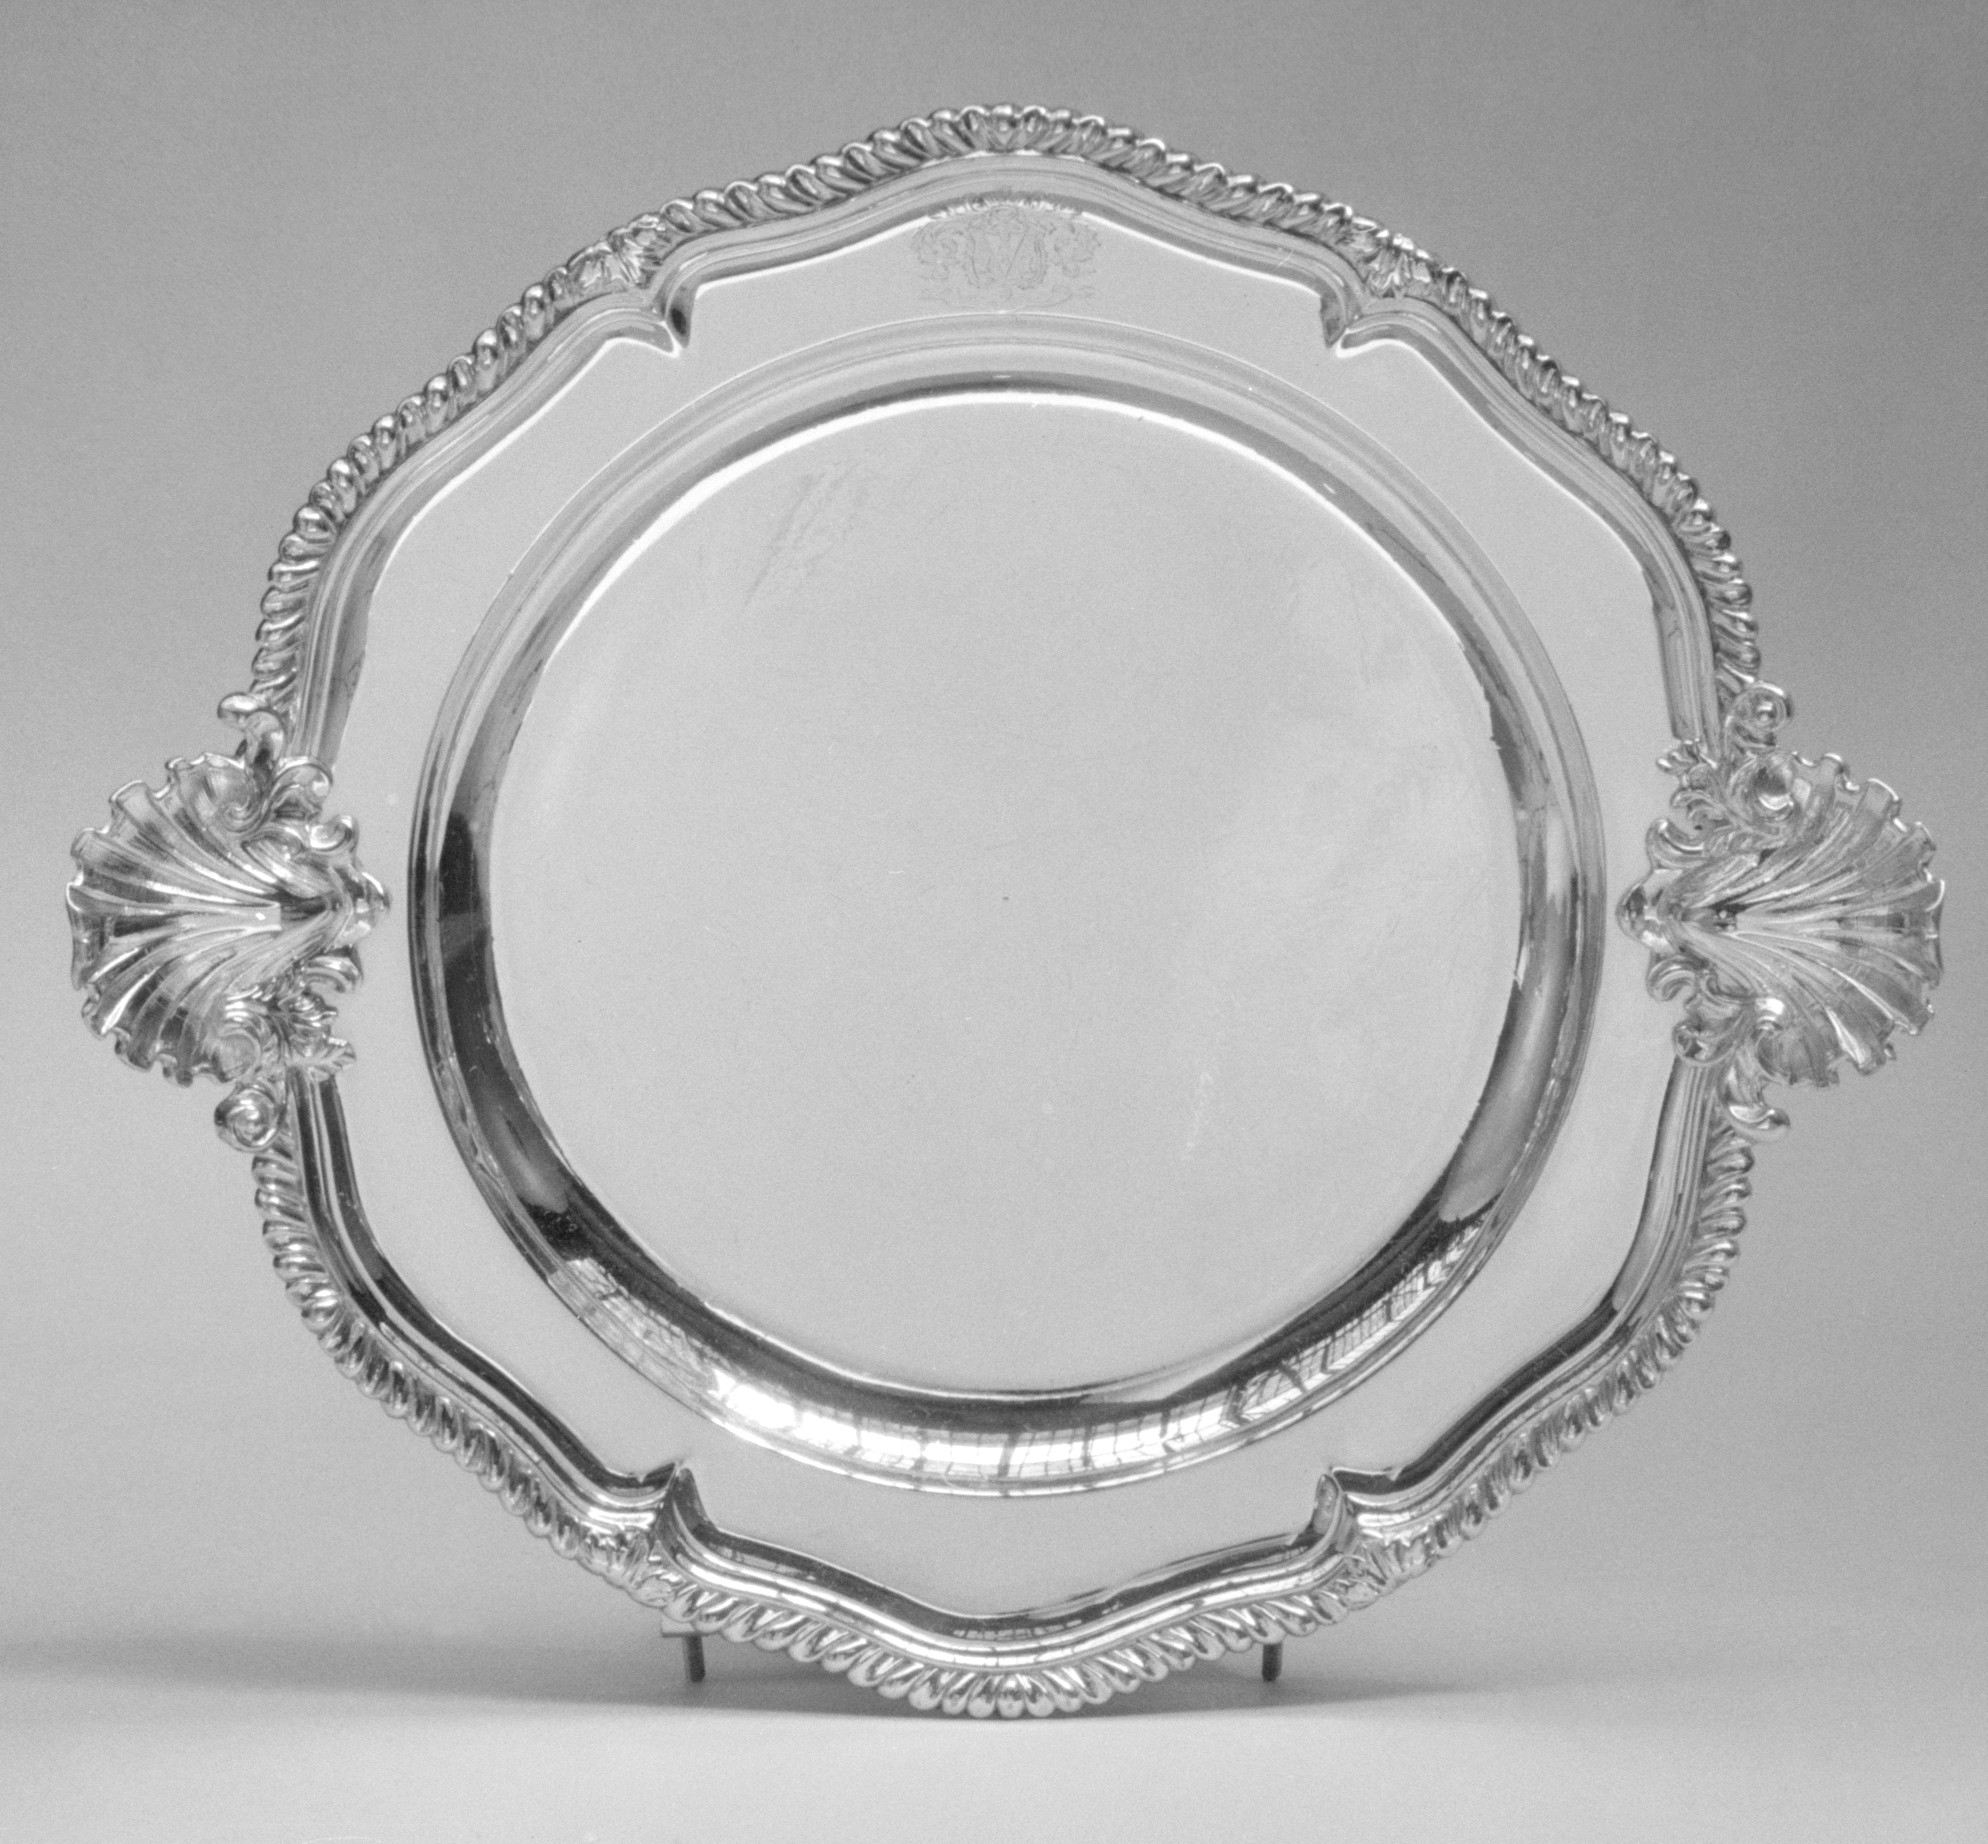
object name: dish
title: Dish (one of a graduated set of seven)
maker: paul de lamerie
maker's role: maker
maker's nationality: british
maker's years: 1688-1751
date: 1741-1742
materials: silver